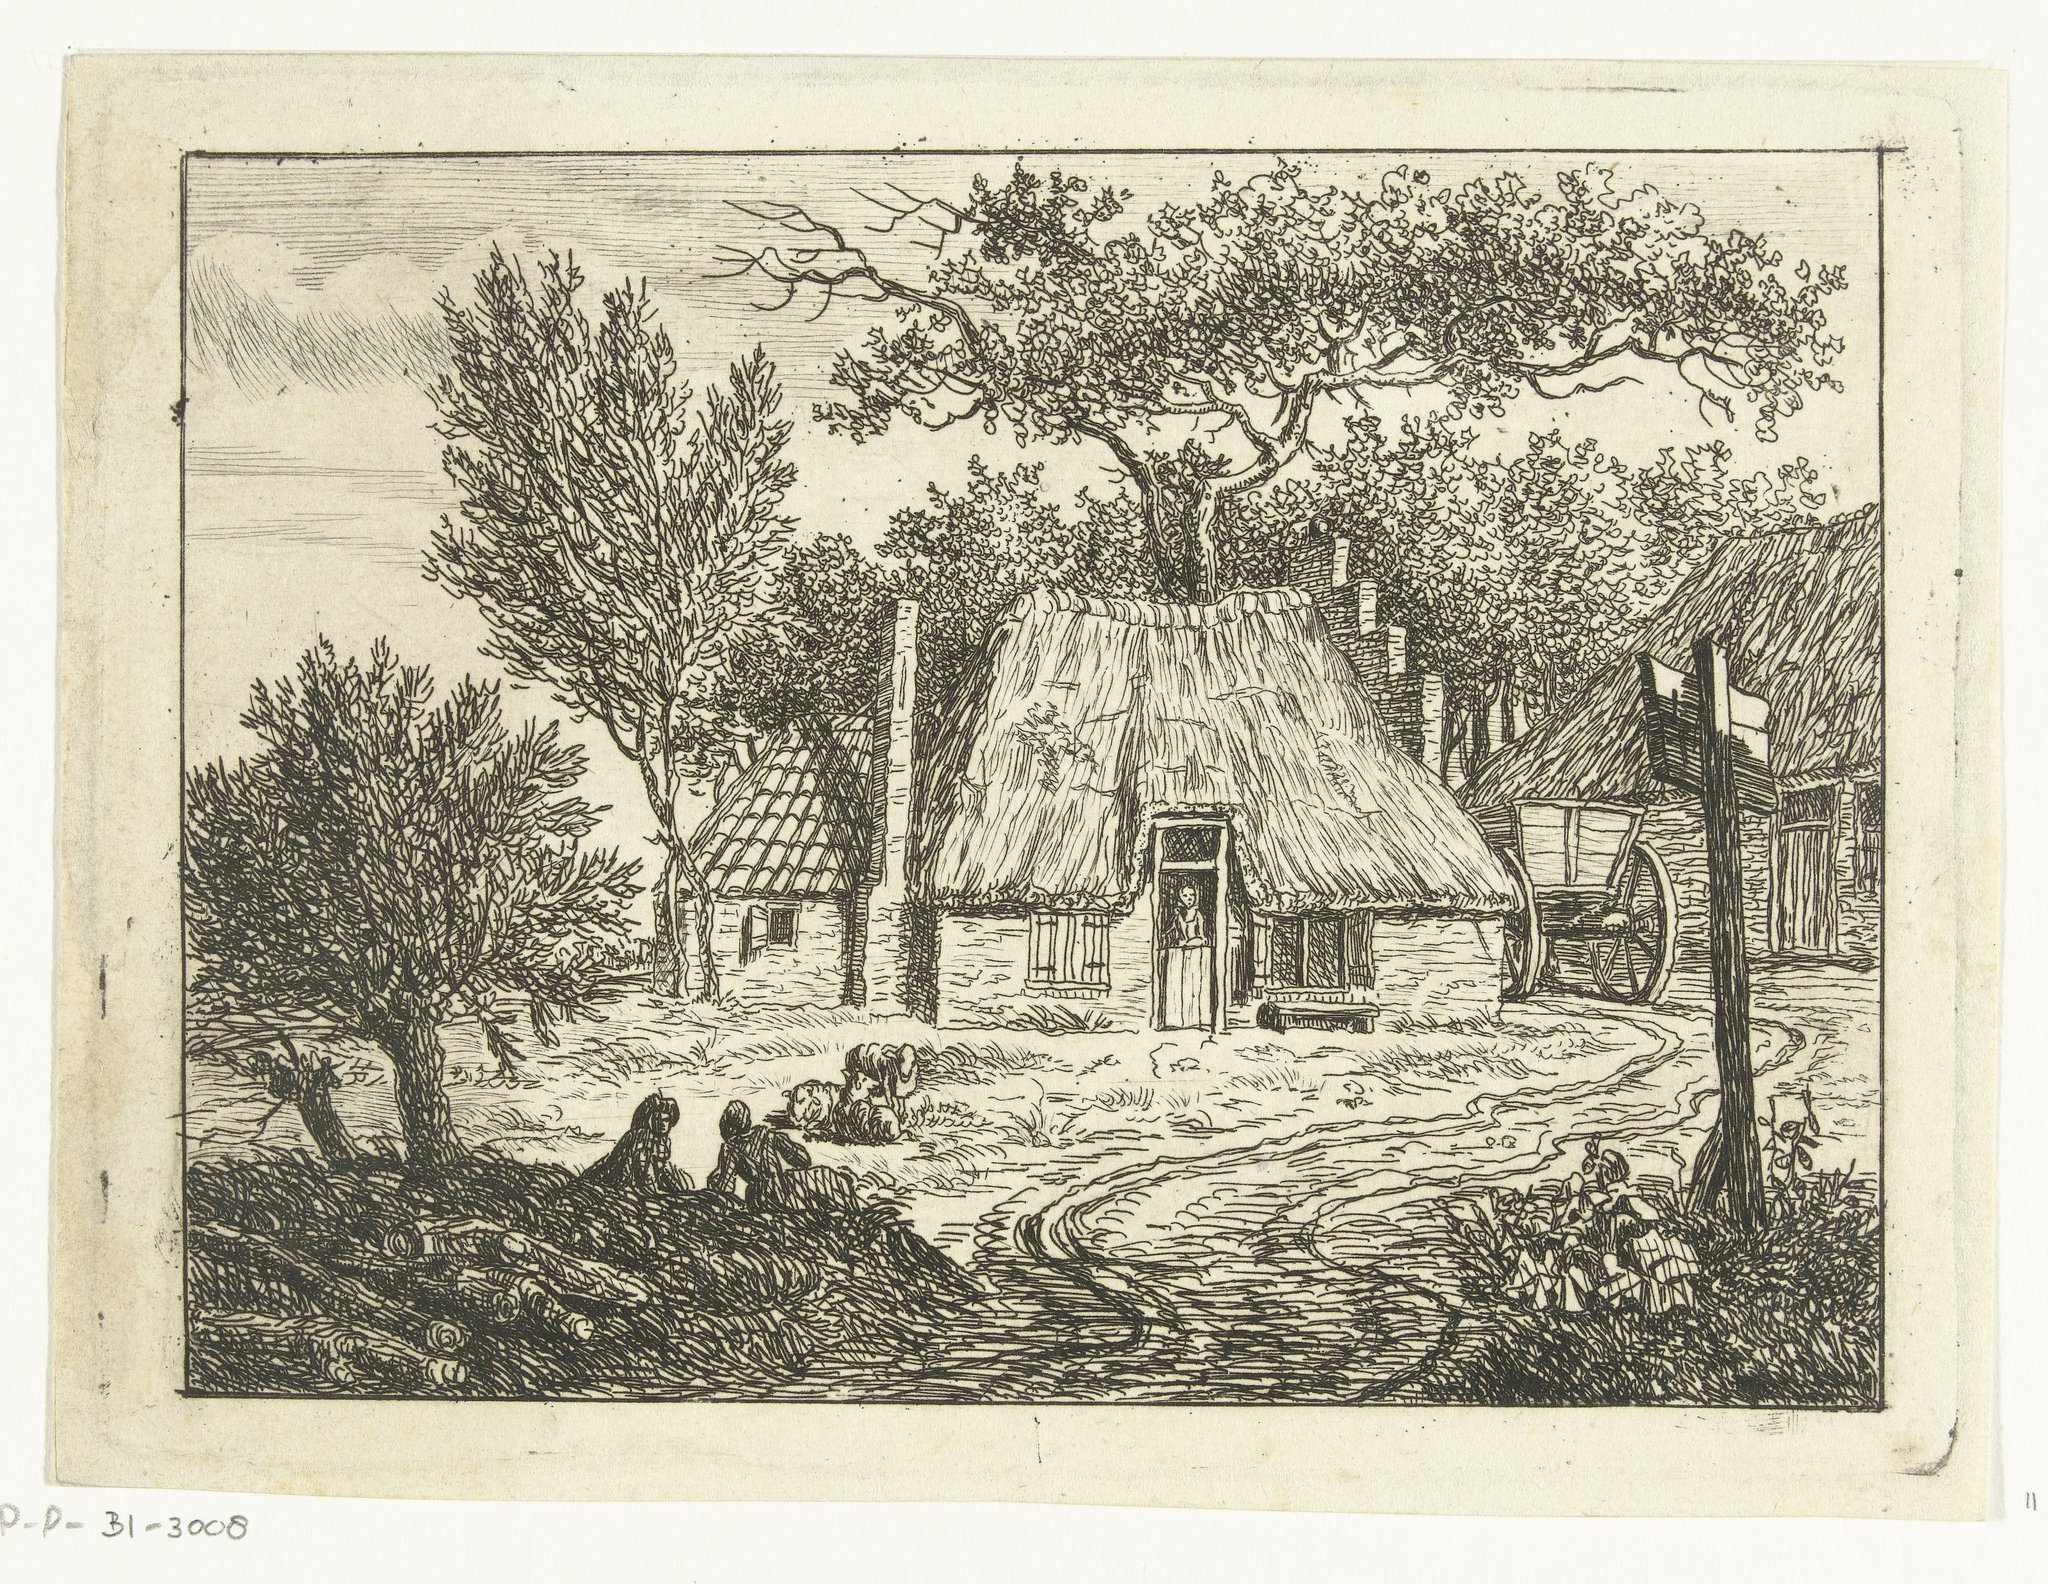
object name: print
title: Boerderij op de Amstelveense Weg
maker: anthonie van den bos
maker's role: draughtsman, print maker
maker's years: 1763-1838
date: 1778-1838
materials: paper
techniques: etching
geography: netherlands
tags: farm or solitary house in landscape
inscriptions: collector's mark: Lugt 2228